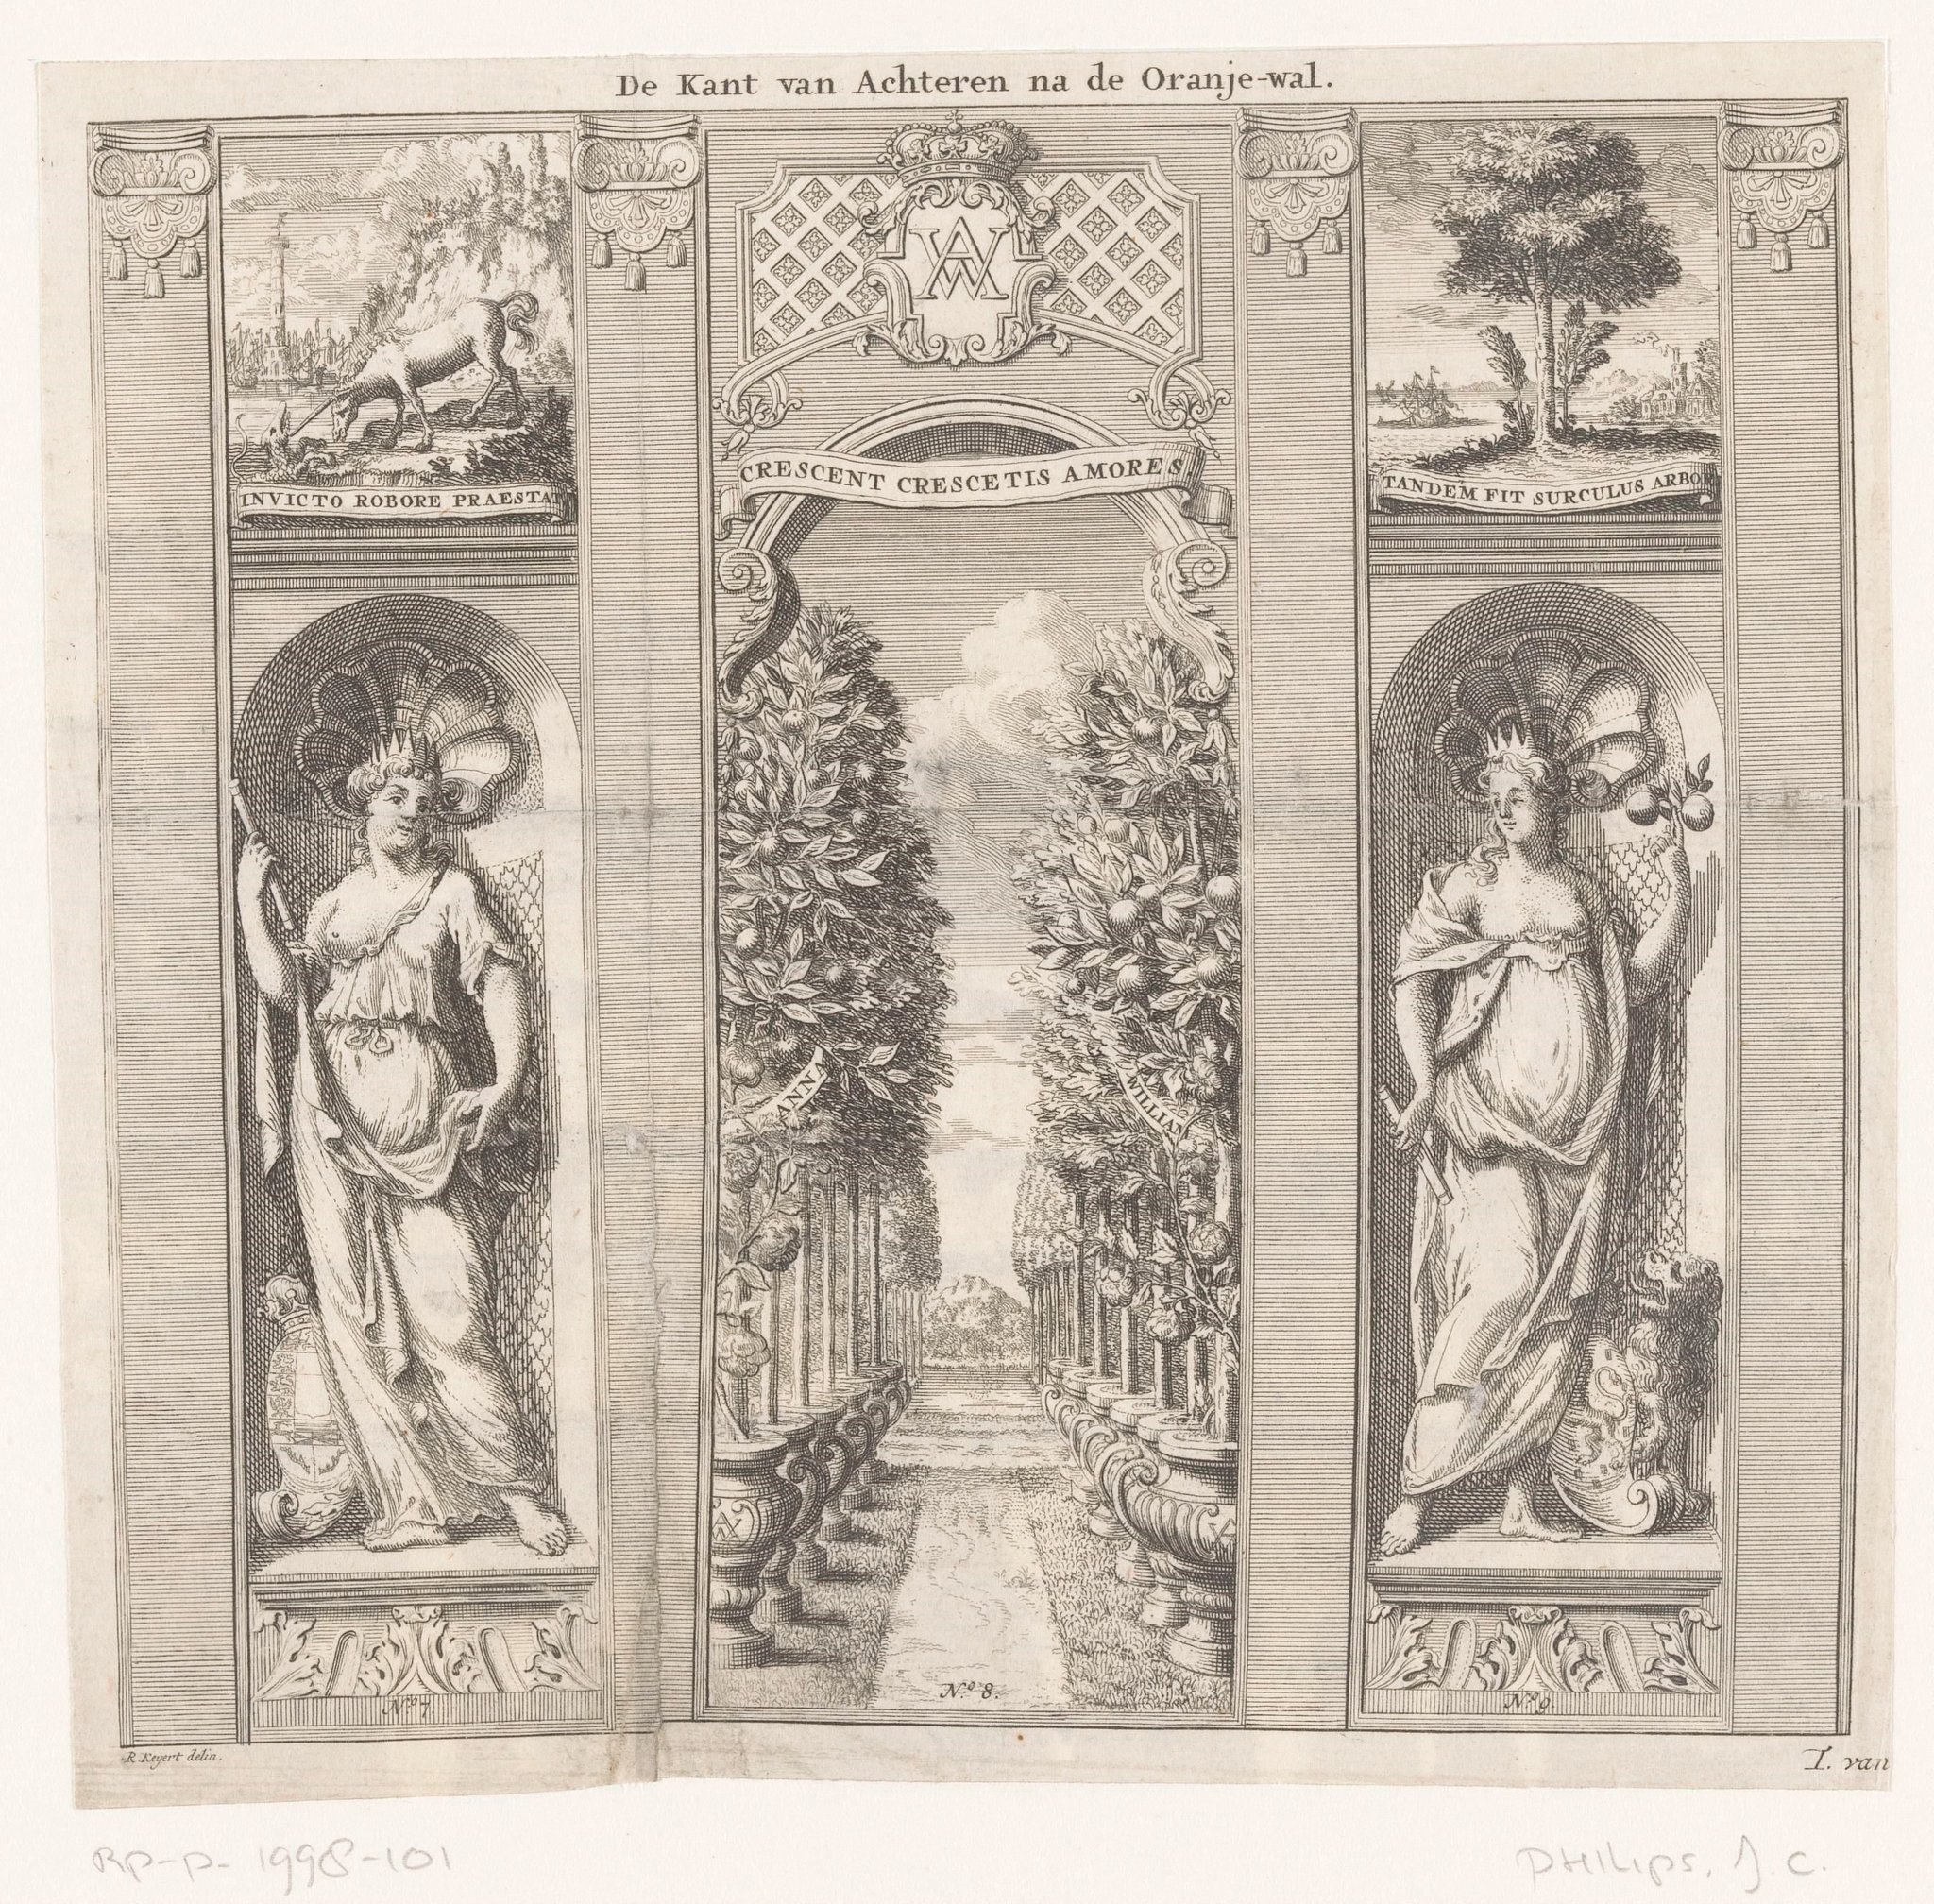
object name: book illustration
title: Personificaties van de geslachten Hannover en Nassau en een orangerie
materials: paper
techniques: engraving, etching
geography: leeuwarden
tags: willem iv (prins van oranje-nassau), anna van hannover, public festivities at marriage of royal persons (+ illumination, fire-works ~ festive activities)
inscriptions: collector's mark: Lugt 2228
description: De allegorische voorstellingen aangebracht op de achterzijde van een tempel die 11 mei 1734 te Leeuwarden temidden van aangestoken vuurwerk stond ter gelegenheid van de inkomst van het pasgetrouwde paar prins Willem IV en prinses Anna, gehuwd op 25 maart 1734. Links boven verdrijft een eenhoorn een krokodil, daaronder een personificatie van het geslacht van Hannover (No 7), in het midden een orangerie met bomen met de namen Anna en William (No 8), rechts boven een boom met een devies en rechts onder een personificatie van het geslacht van Nassau (No 9).